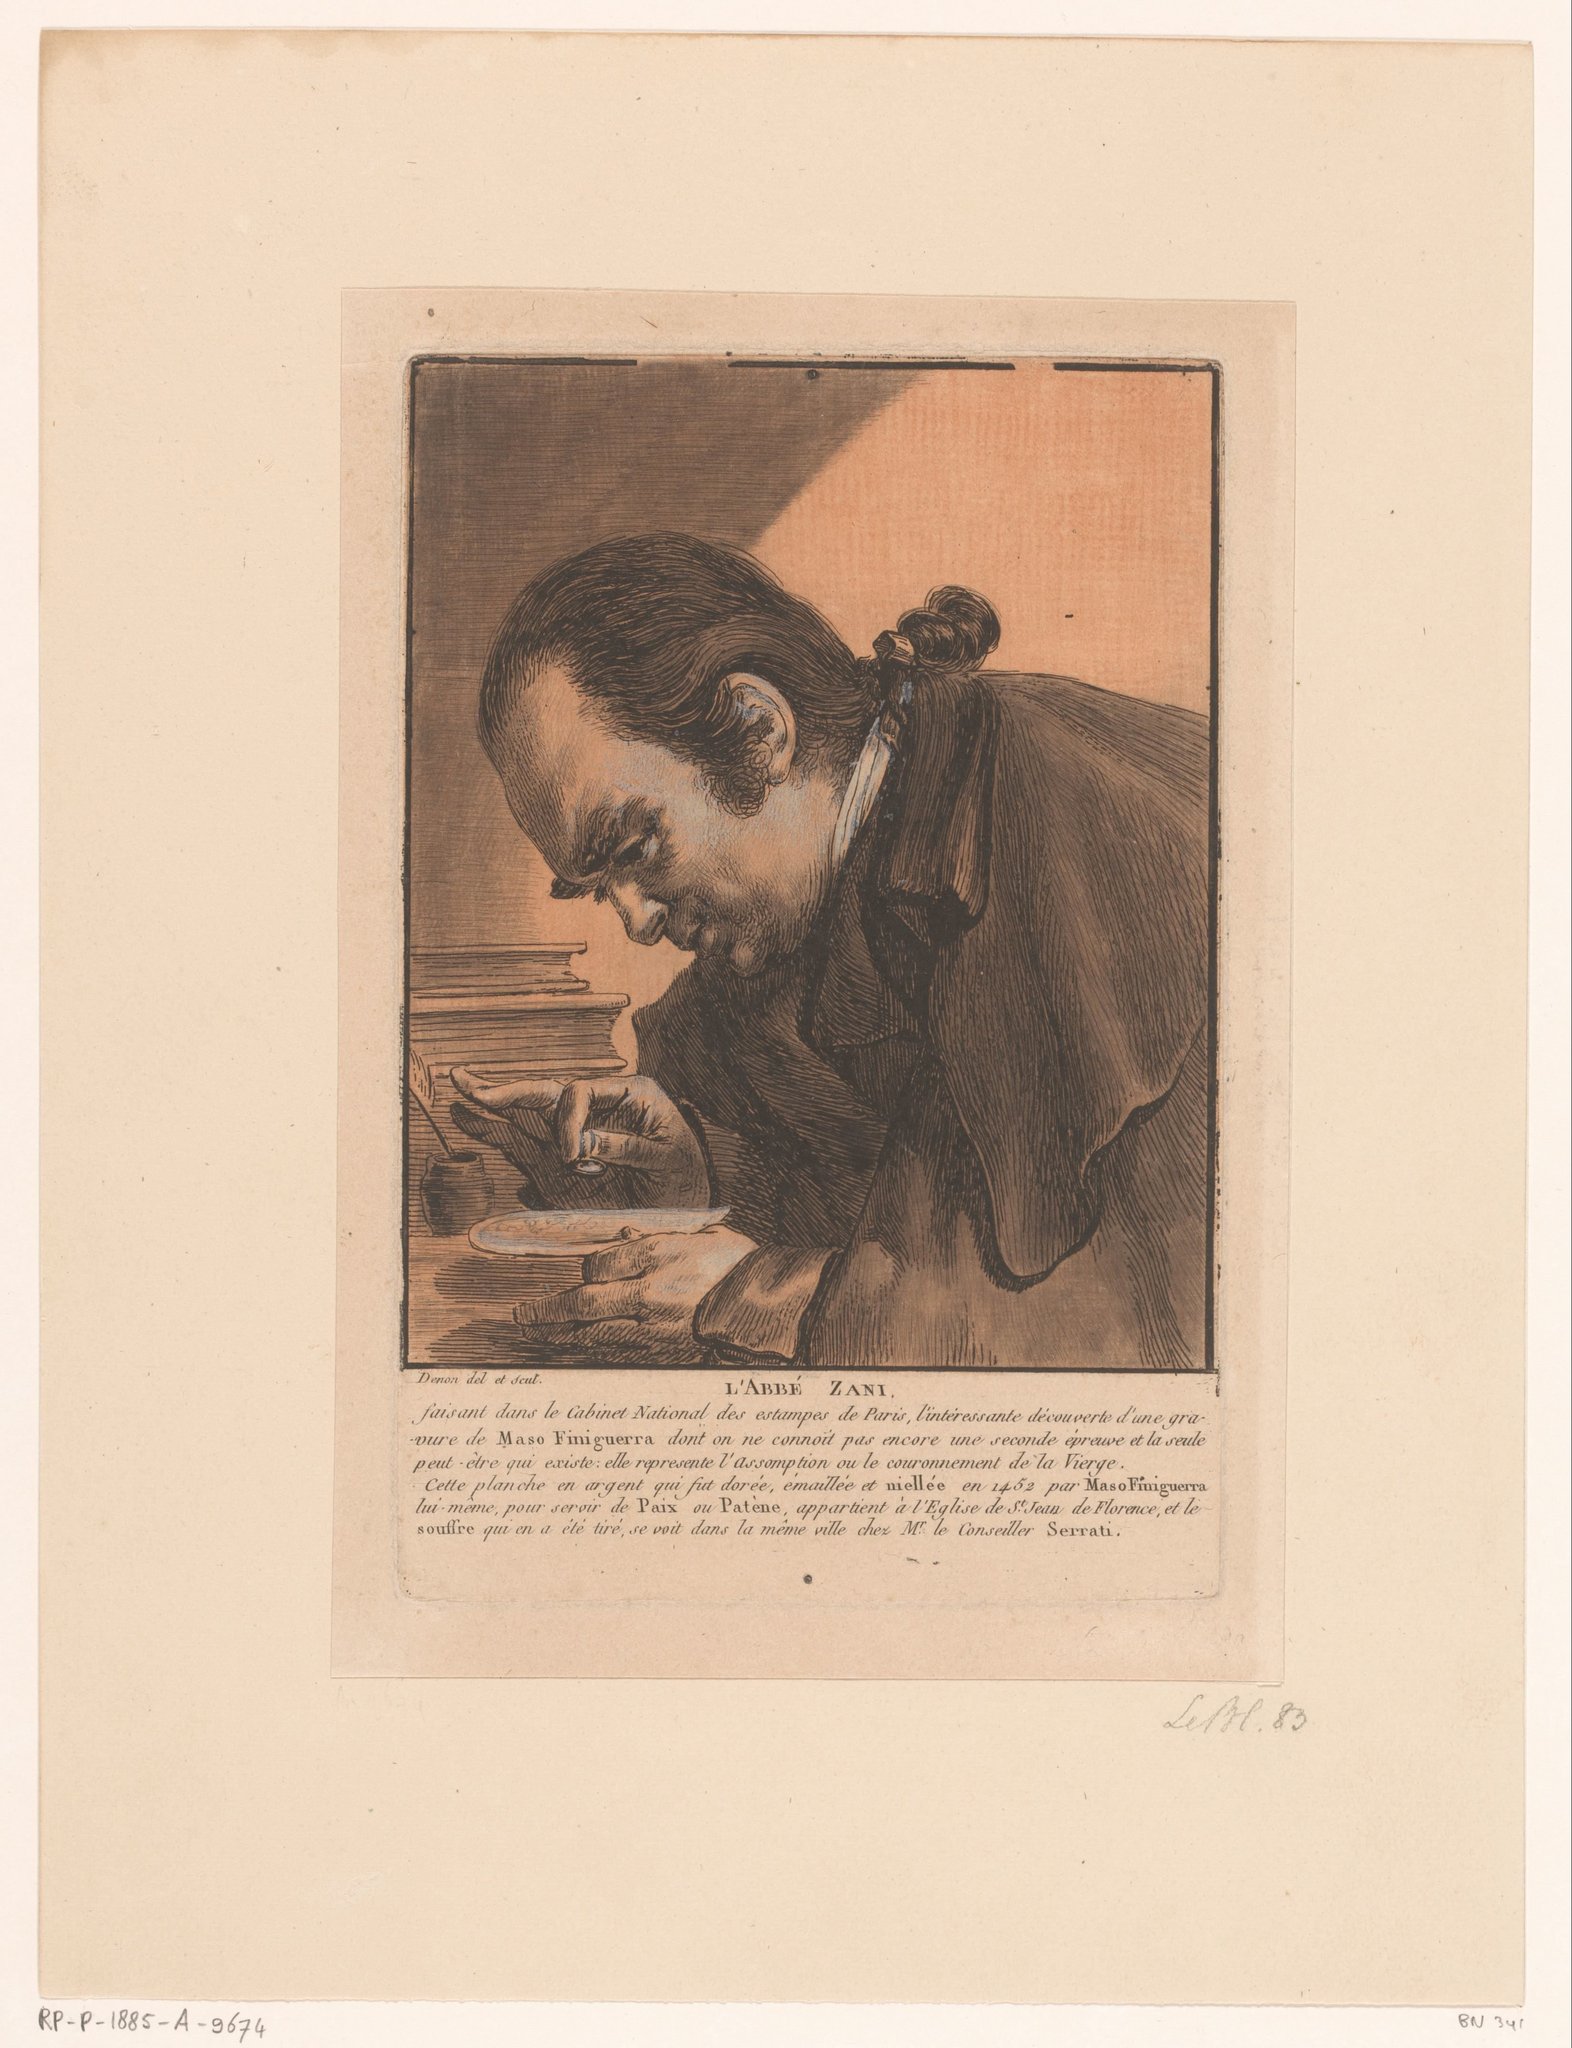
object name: print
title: Portret van Pietro Zani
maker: dominique vivant denon (baron)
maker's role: draughtsman, print maker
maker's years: 1747-1825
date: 1757-1825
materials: paper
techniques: aquatint, etching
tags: historical persons, magnifying glass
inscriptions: collector's mark: Lugt 2228